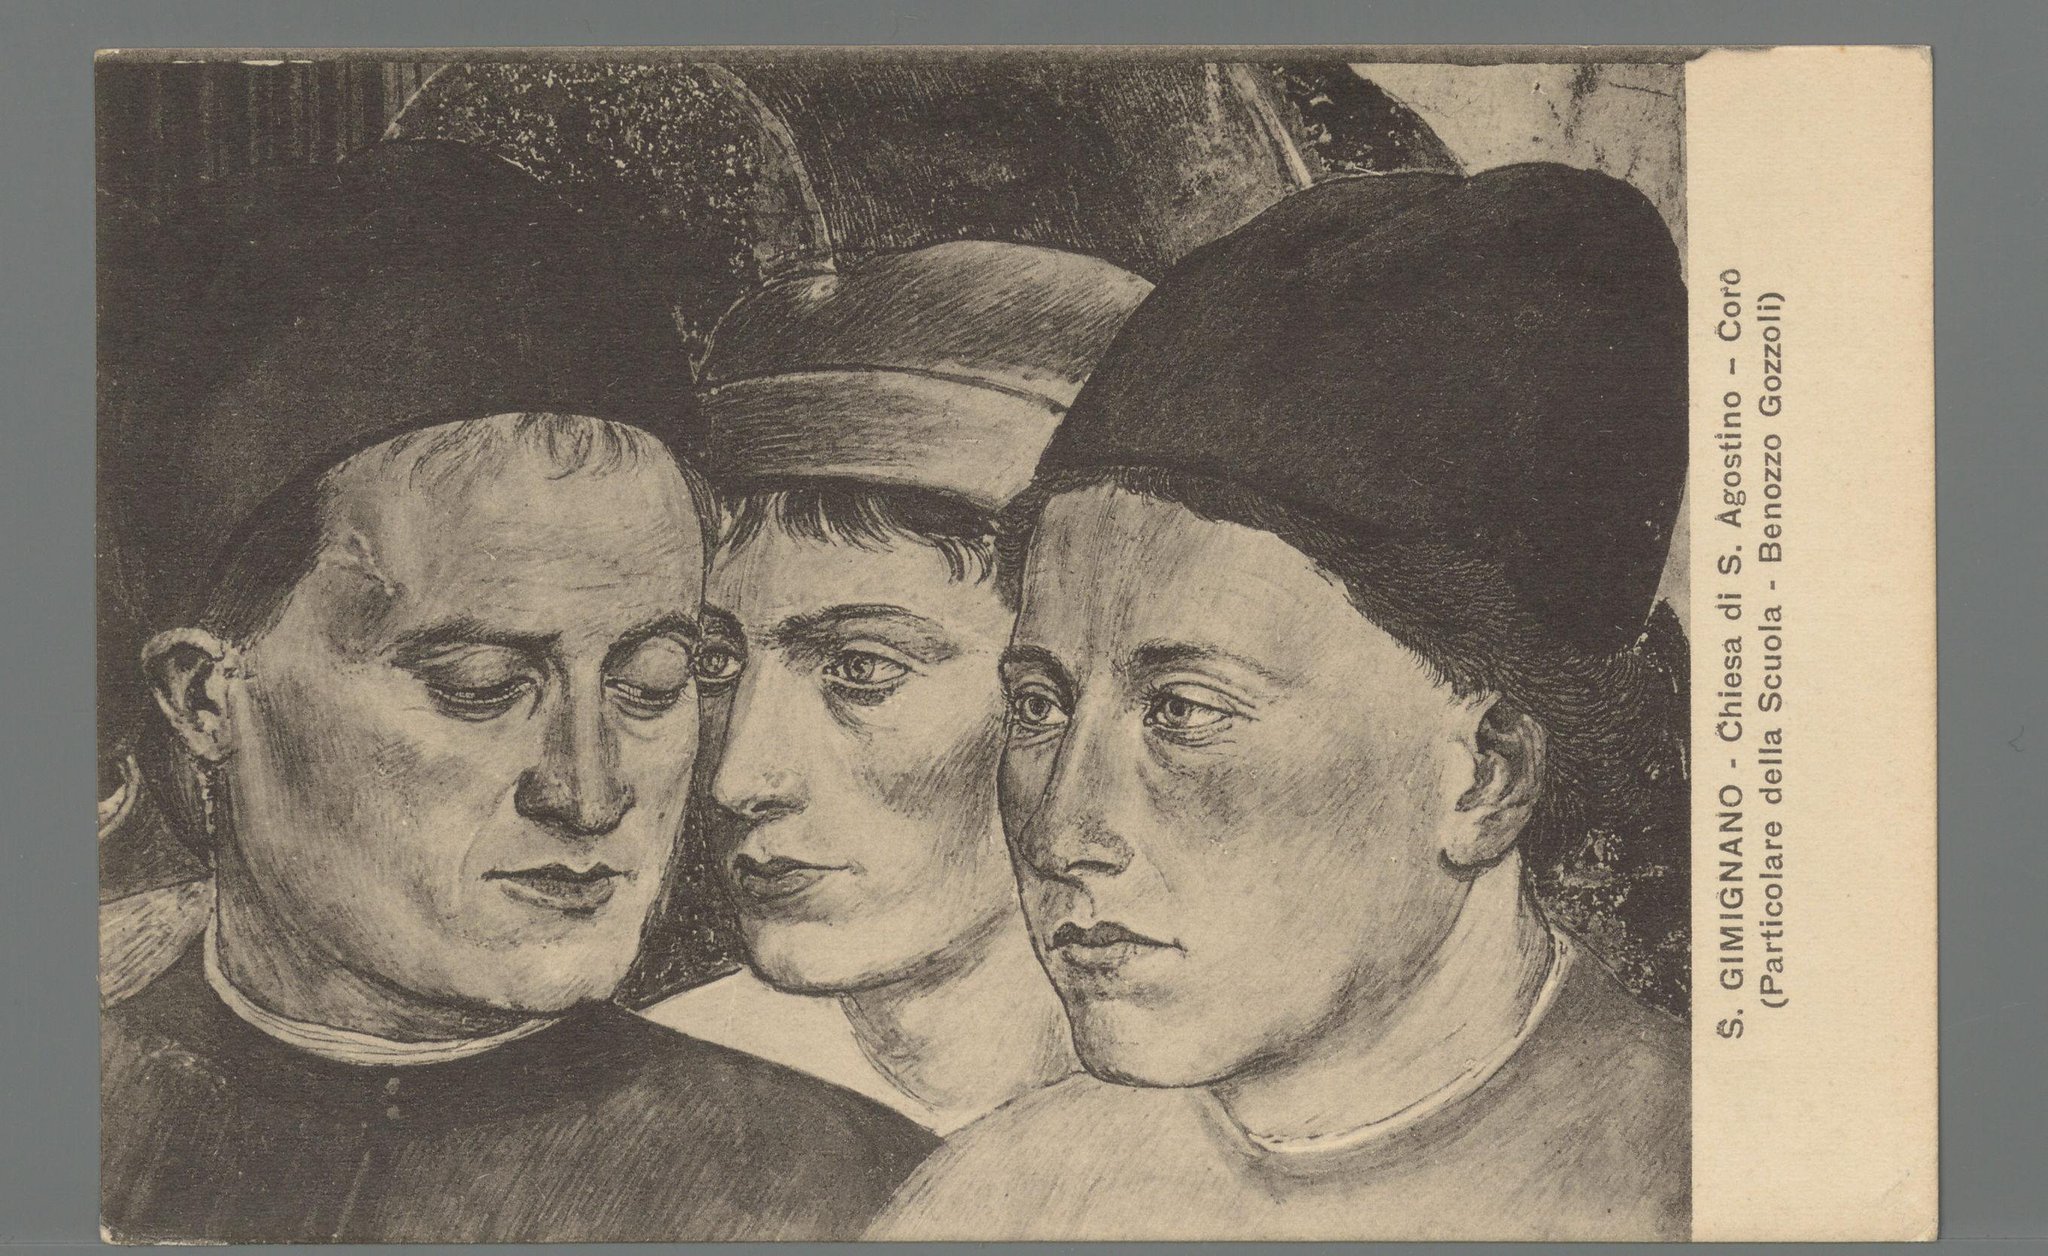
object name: ansichtkaart, prentbriefkaart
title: S. Gimignano - Chiesa di S. Agostino - Coro (Particolare della Scuola - Benozzo Gozzoli)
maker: Anonymous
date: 1906-1930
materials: cardboard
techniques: photograph, writing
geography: san gimignano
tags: interior of church, picture, painting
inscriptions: collector's mark: ‘AFE v S’, postage stamp